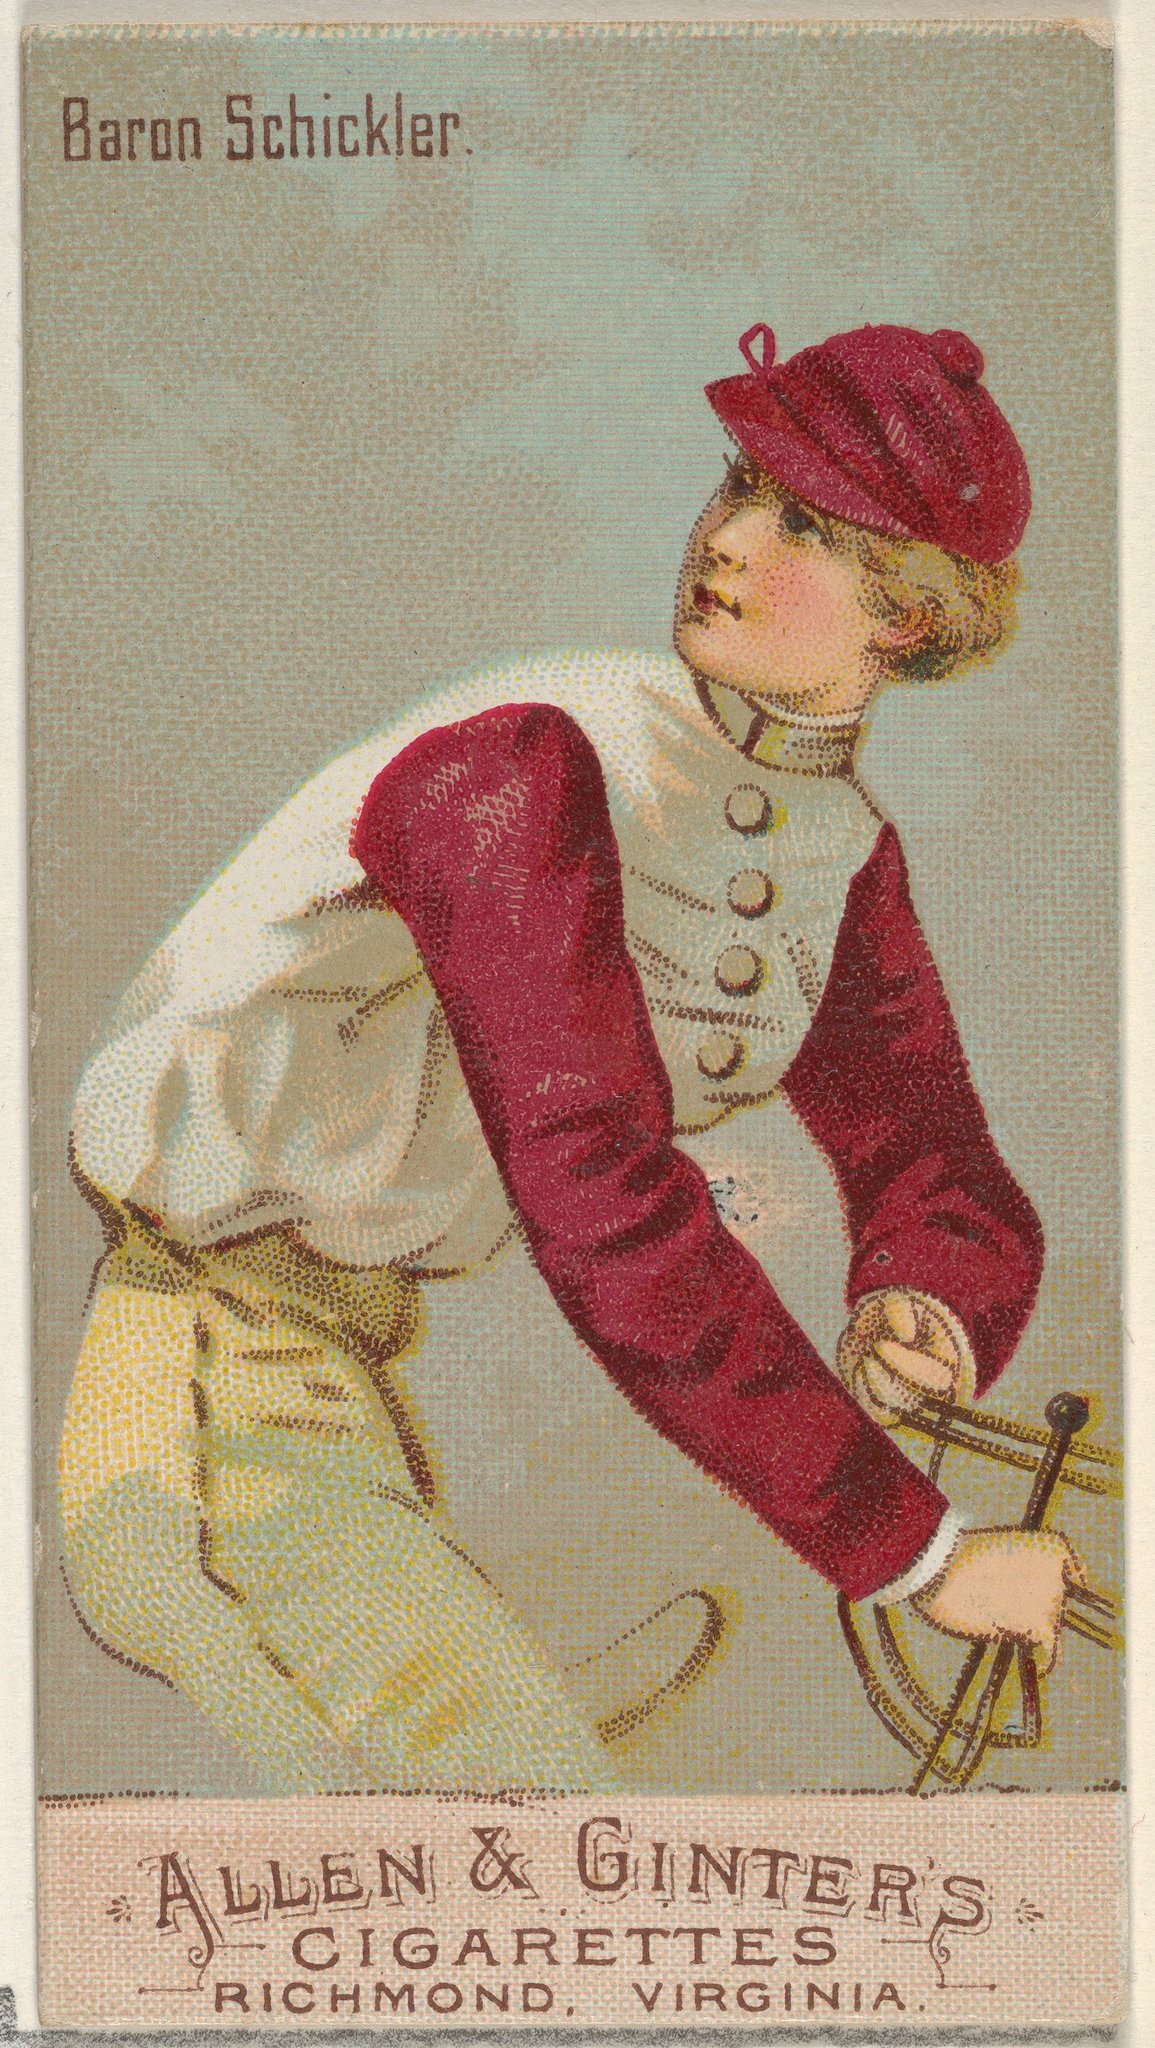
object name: print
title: Baron Schickler, from the Racing Colors of the World series (N22b) for Allen & Ginter Cigarettes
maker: allen & ginter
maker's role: publisher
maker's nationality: american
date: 1888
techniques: color lithograph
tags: women,jockeys